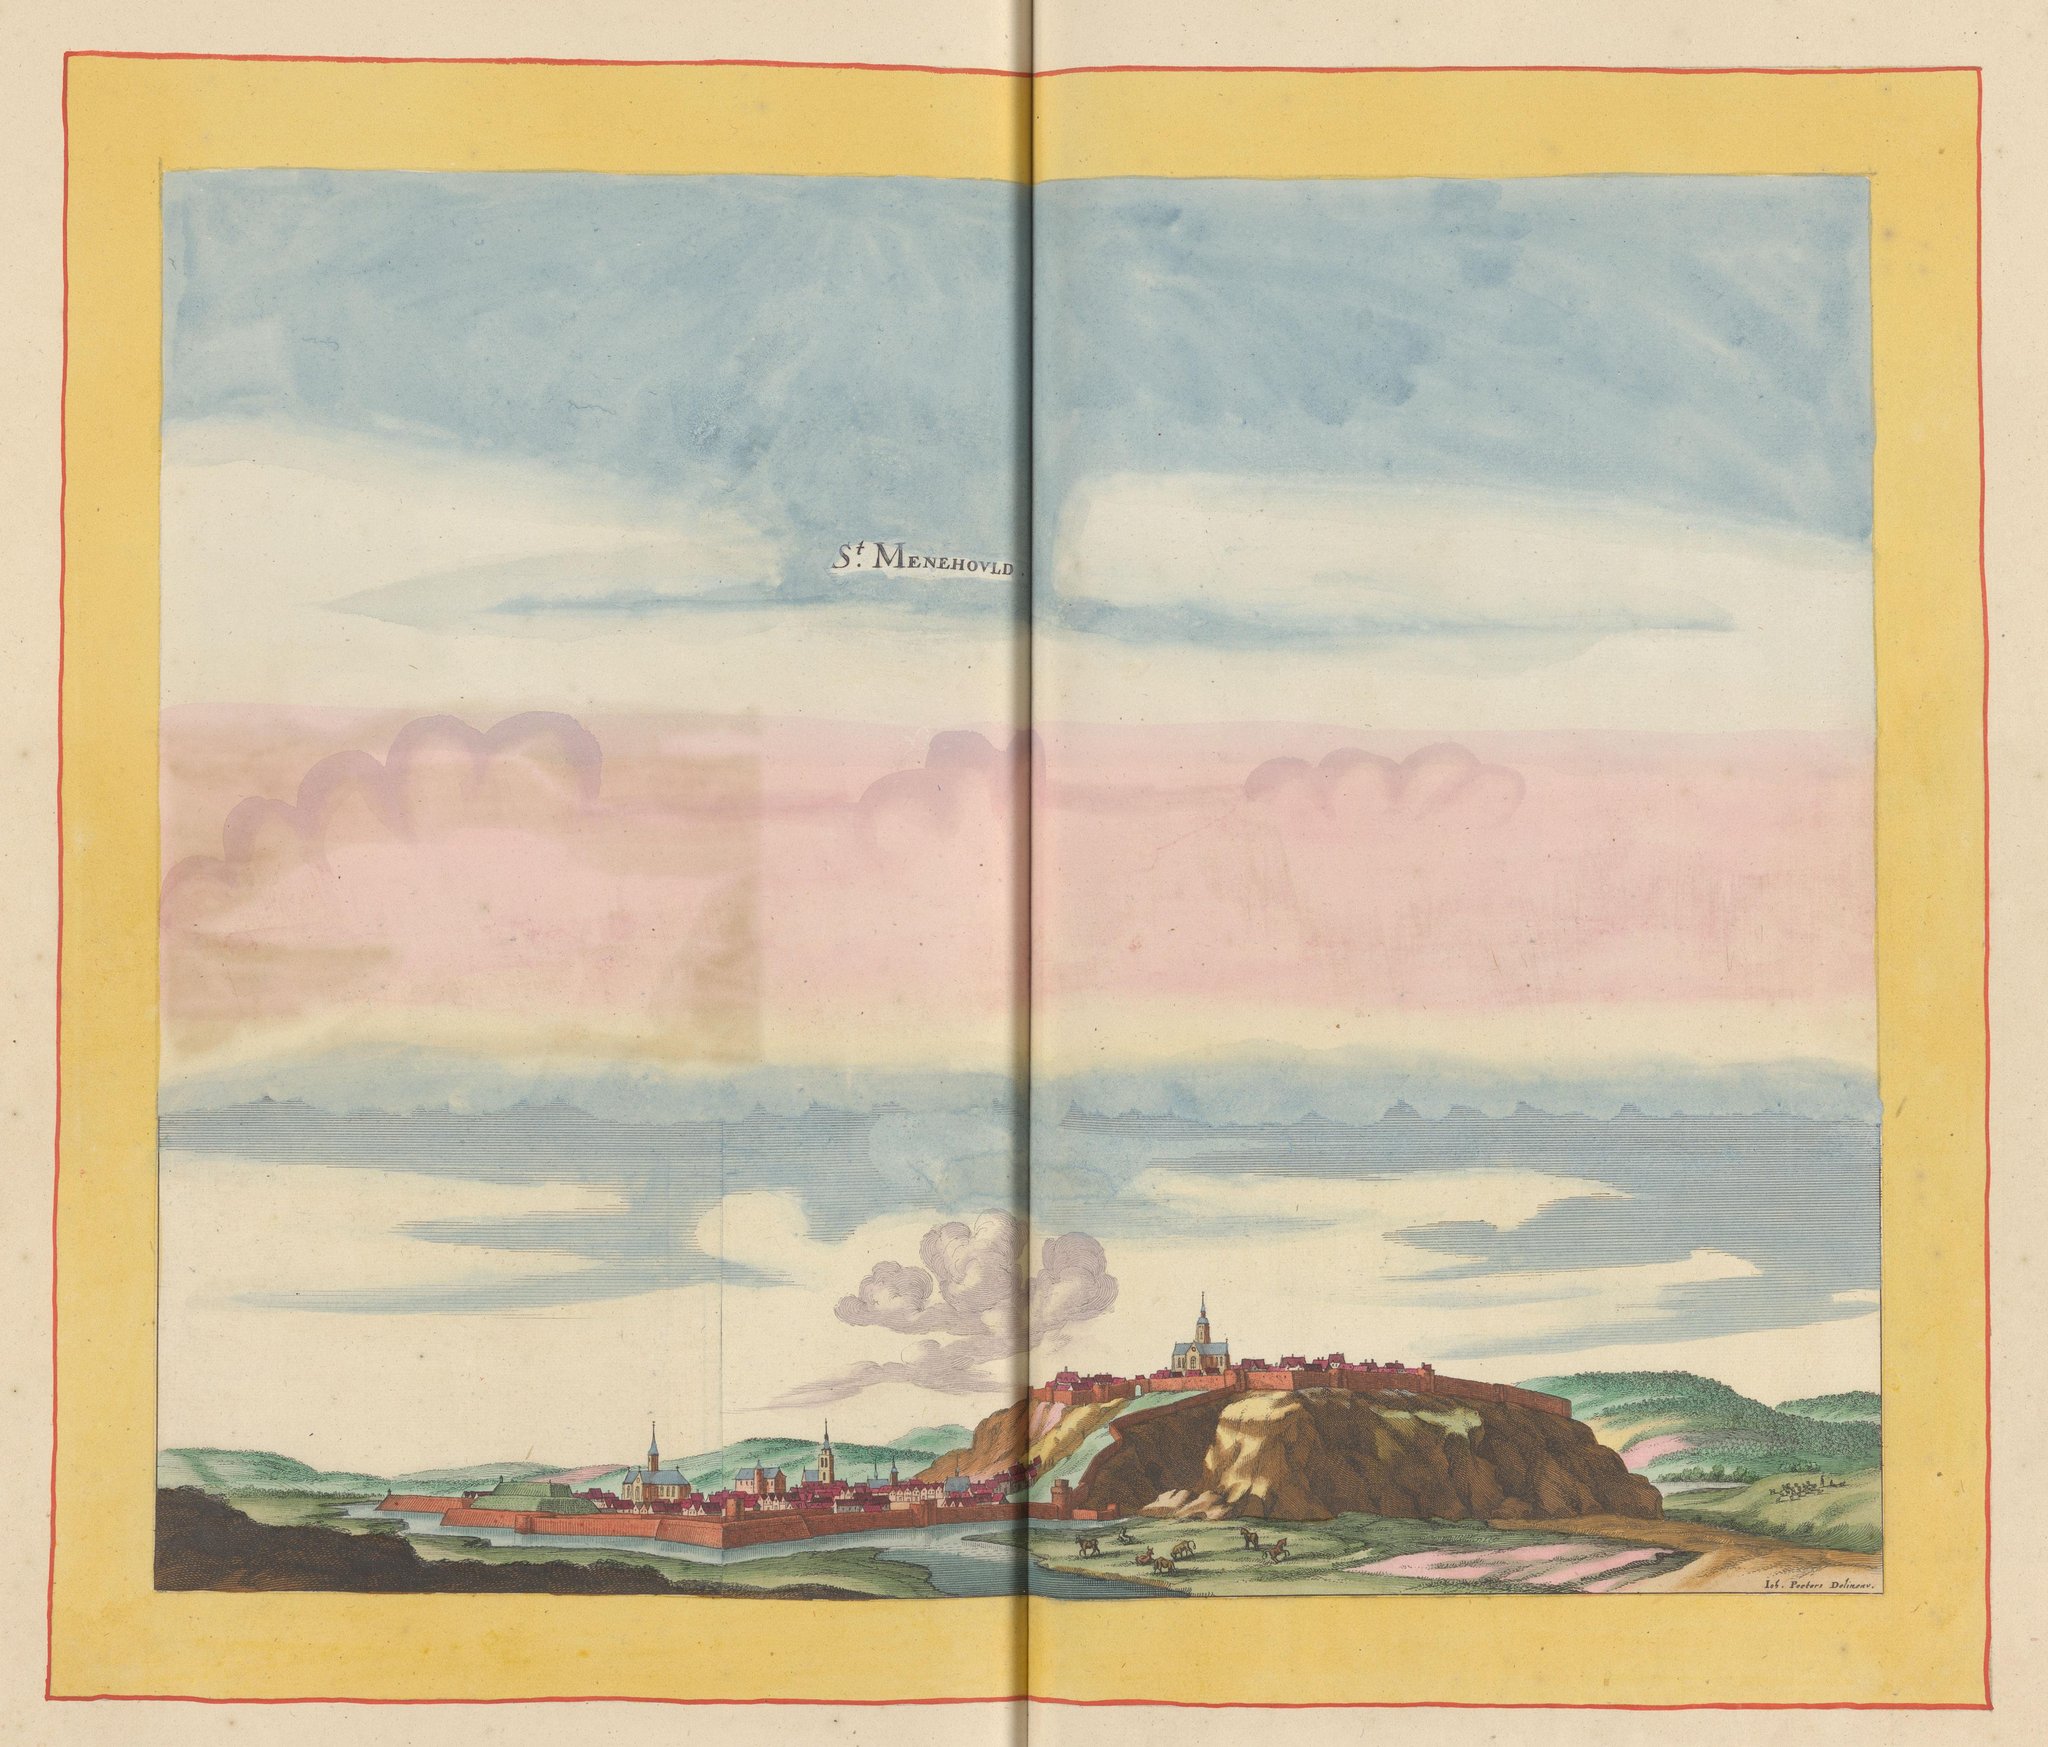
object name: album leaf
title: St. Menehould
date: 1656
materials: paper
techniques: engraving, etching, hand coloring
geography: frankfurt am main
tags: city-view in general; 'veduta'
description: Prent uit: Zeiller, Martin. Topographia Galliae. 13 dln. Frankfurt: Caspar Merian, 1656, dl. 3, na p. 22. Origineel op één blad gedrukt met een gezicht op Mouzon (RP-P-1957-607-166).